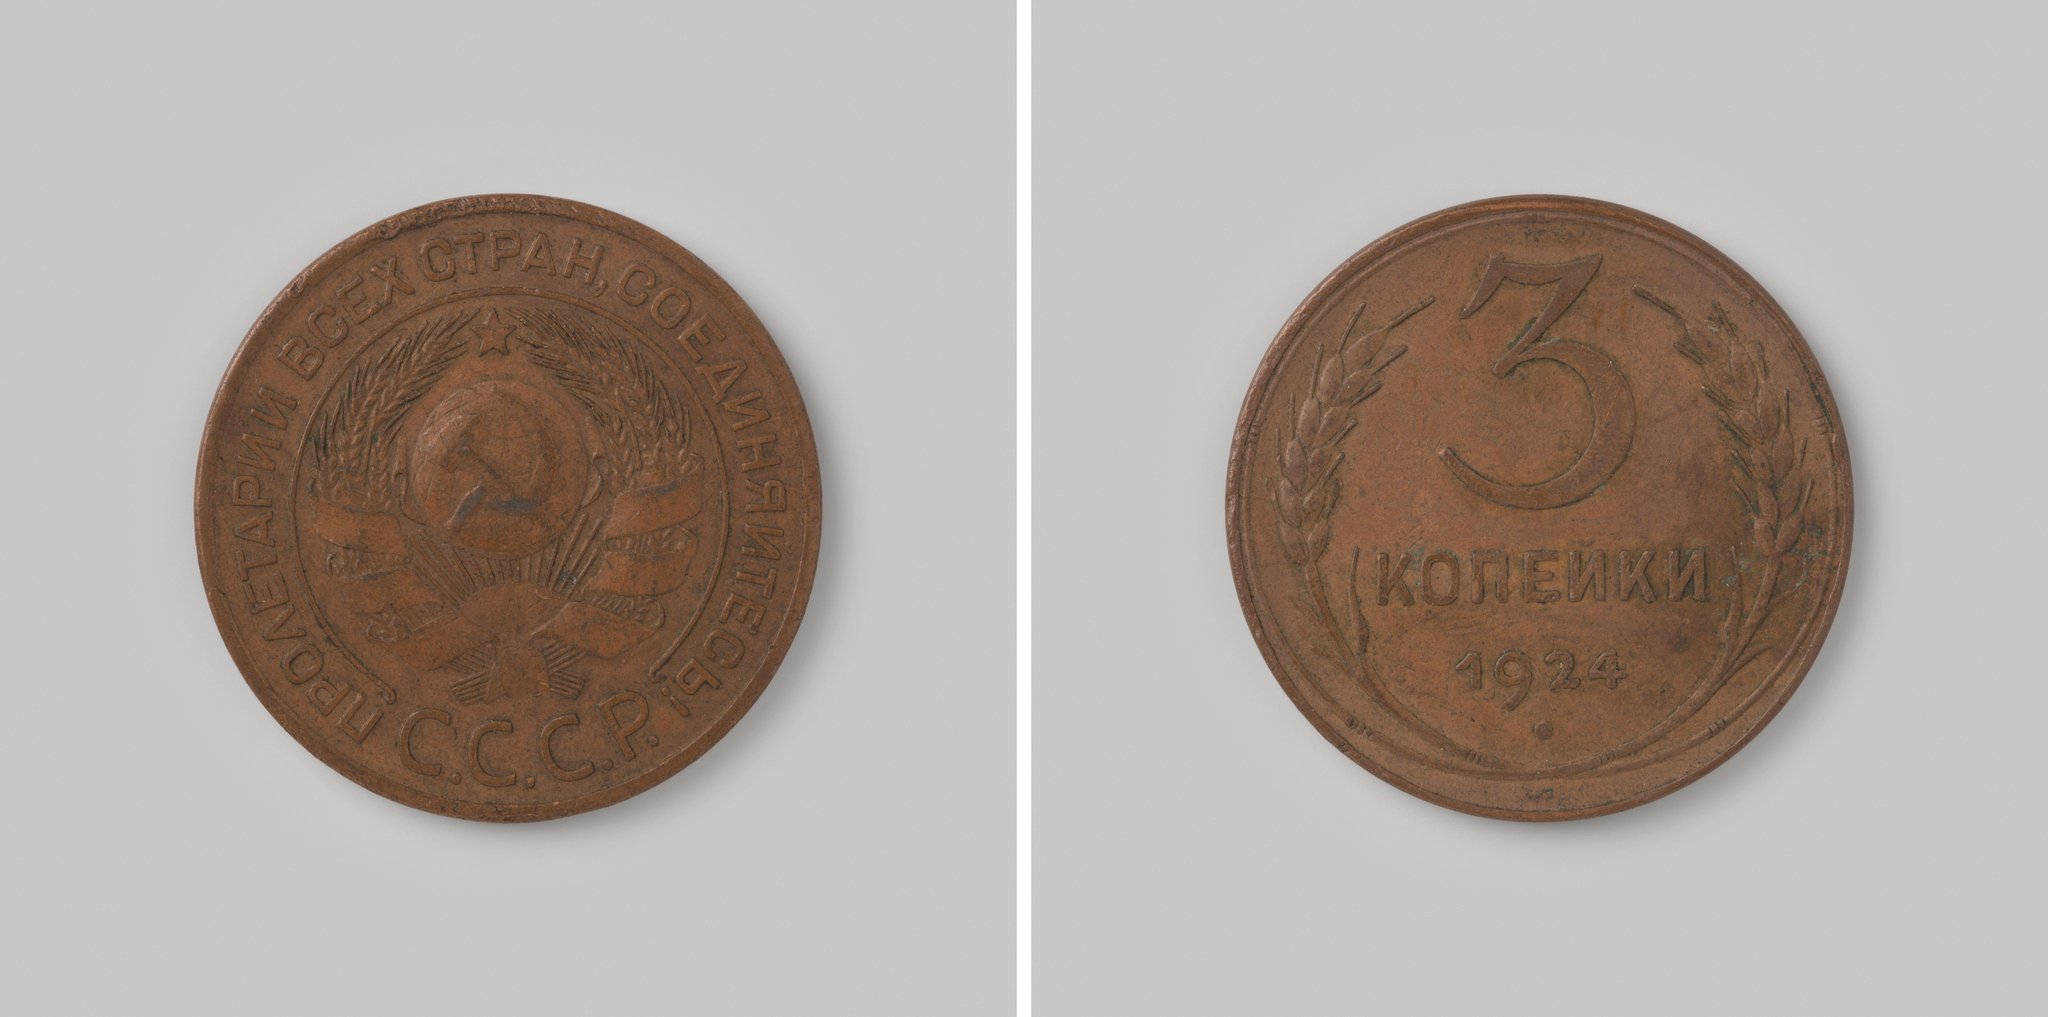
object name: coin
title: Rusland, 3 kopeken, 1924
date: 1924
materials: bronze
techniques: striking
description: Bronzen munt. Voorzijde: wapen van de Sowjet-Unie, waaronder landsaanduiding in Cyrillische letters S,S,S en R. Keerzijde: tussen twee gekruiste takken waarde-aanduiding in twee regels, waaronder jaartal. Gladde rand.